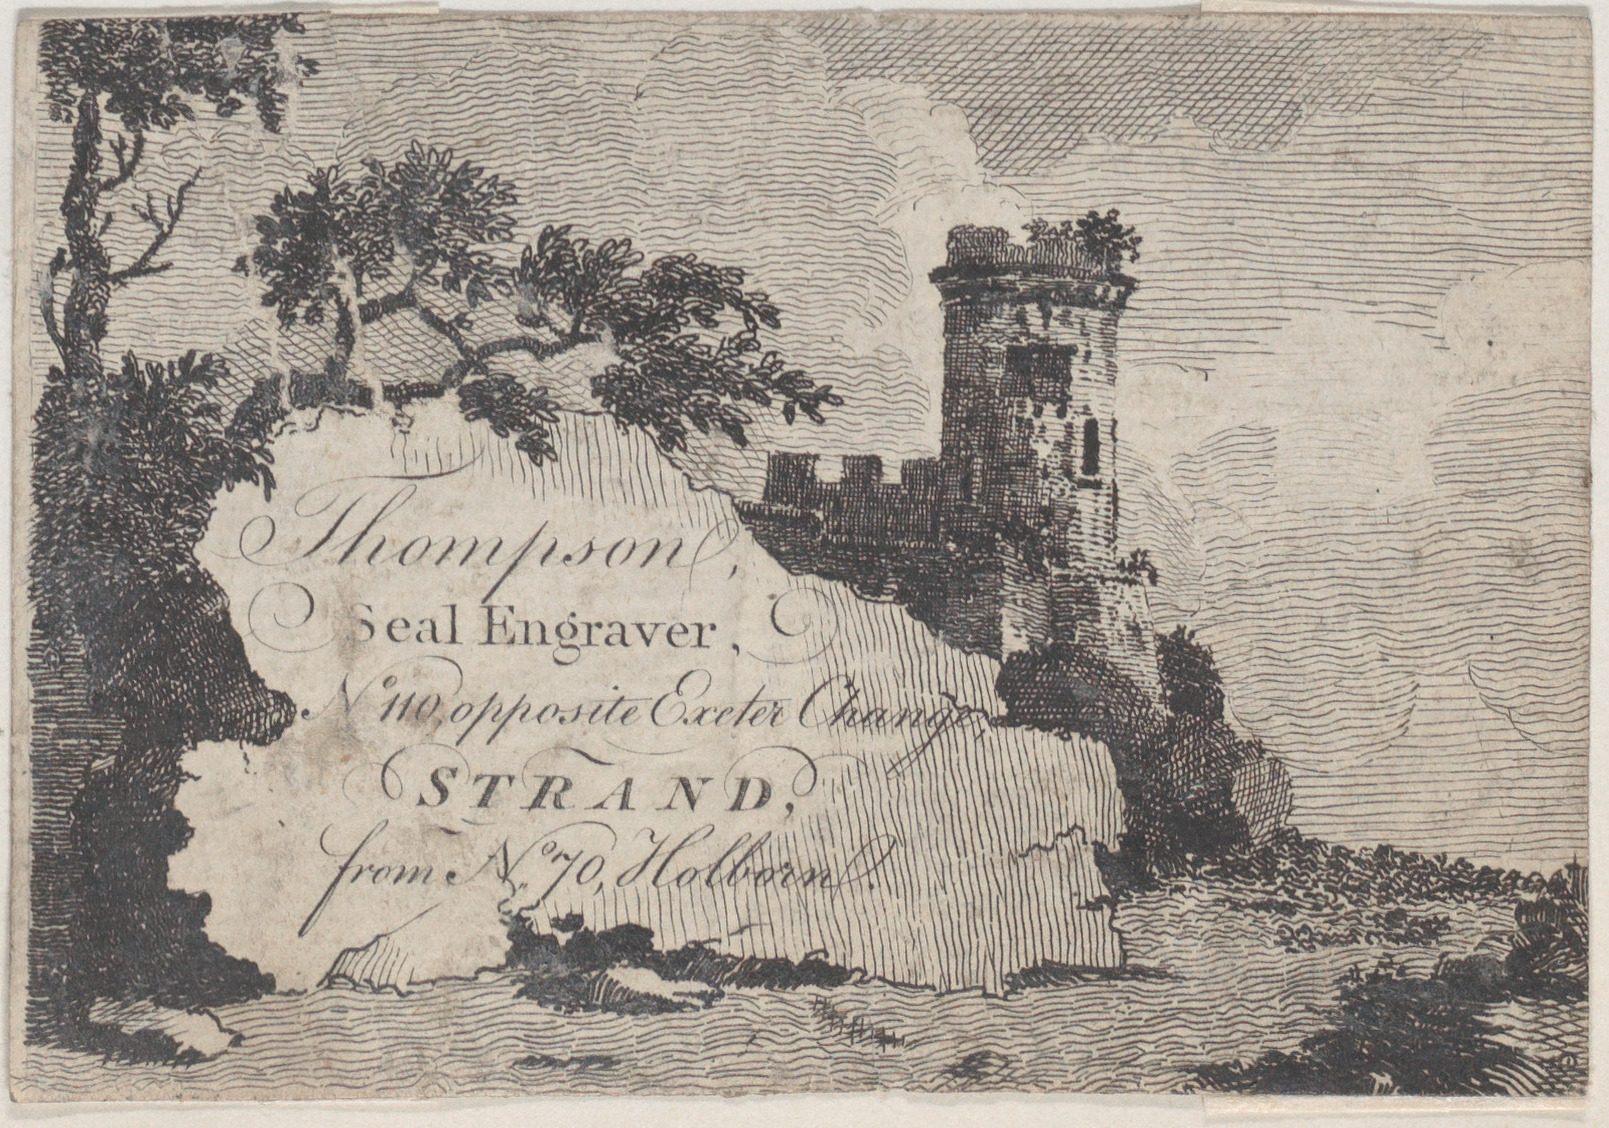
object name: print, trade card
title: Trade Card for Thompson, Seal Engraver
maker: anonymous, british, 19th century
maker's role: artist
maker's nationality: british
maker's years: 1800-1900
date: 1801-1900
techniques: engraving